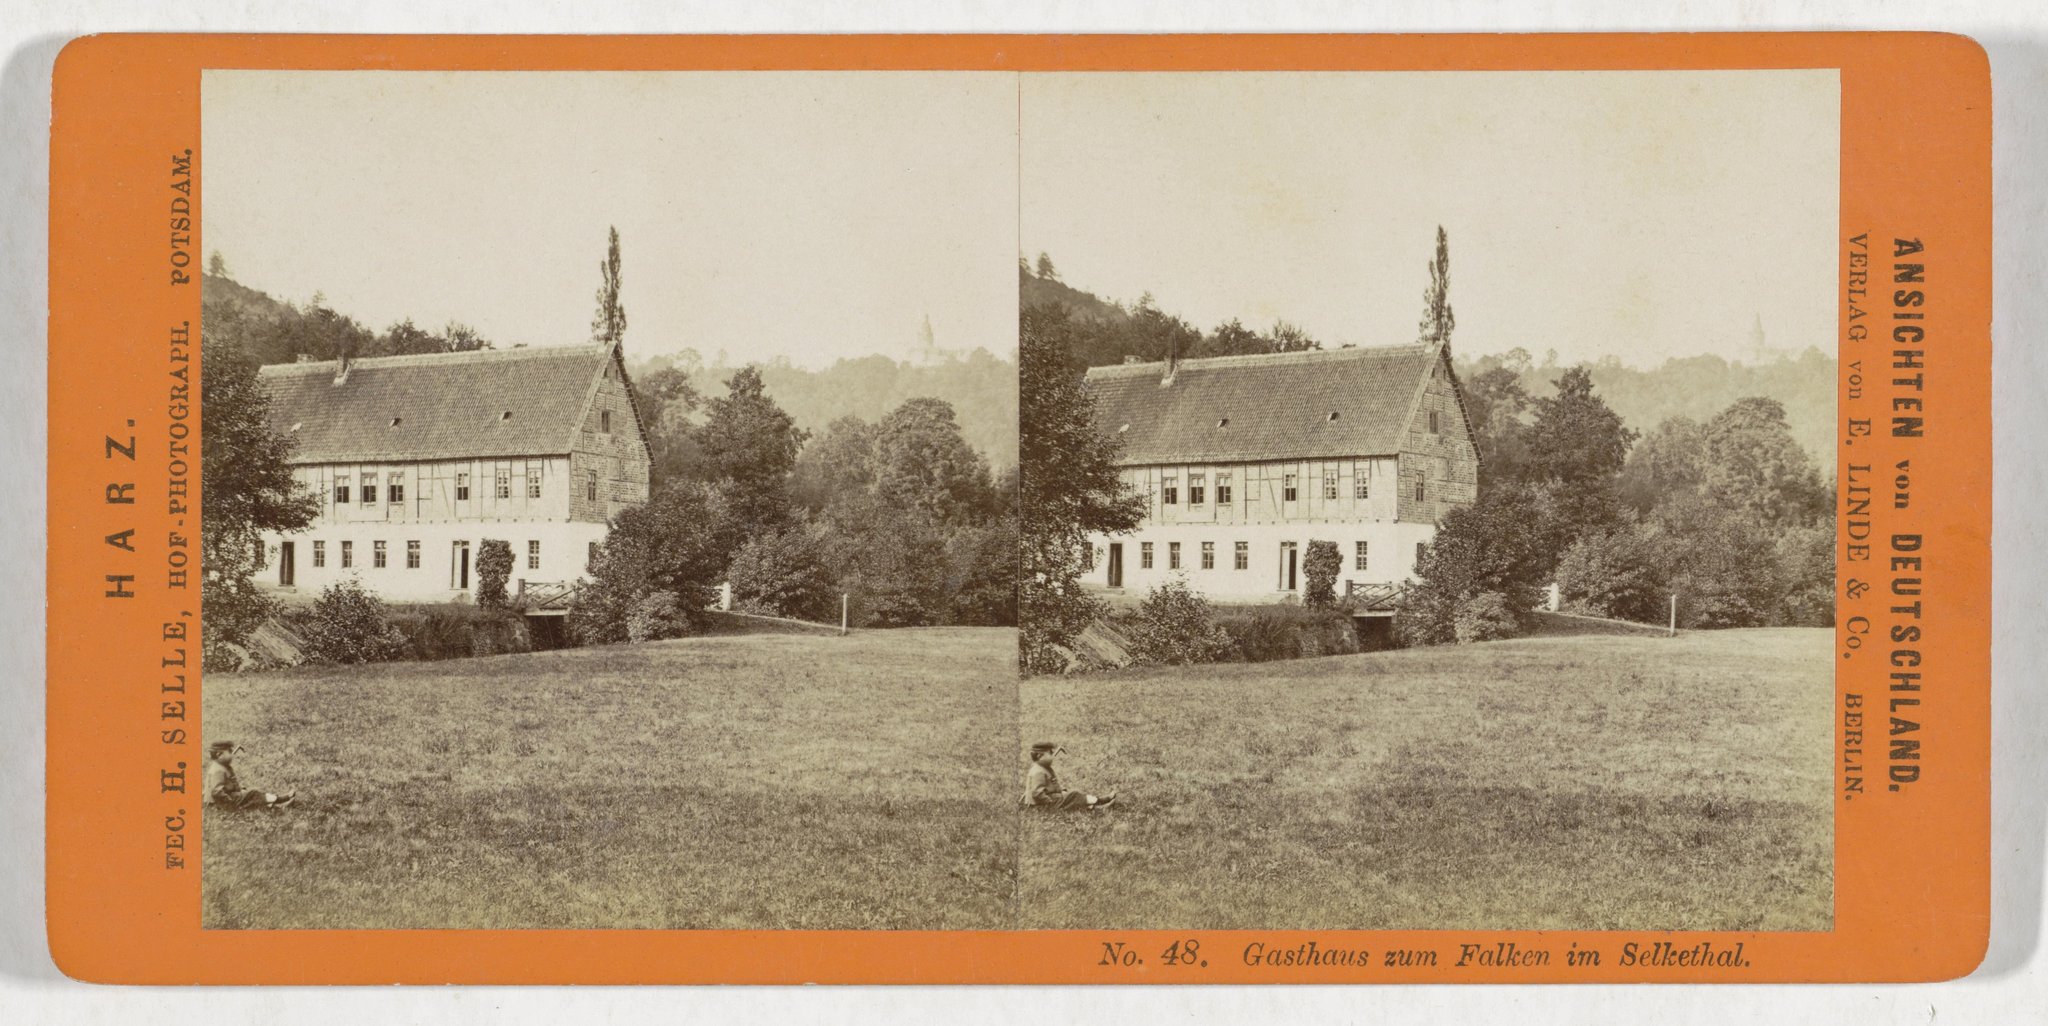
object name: stereograph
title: Ansichten von Deutschland / Harz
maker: hermann selle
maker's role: fotograaf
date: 1868-1890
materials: cardboard, paper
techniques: albumen print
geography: falkenstein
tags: hotel, hostelry, inn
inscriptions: inscription: ‘Hof-Photograph. Potsdam.’, number: ‘No. 48.’